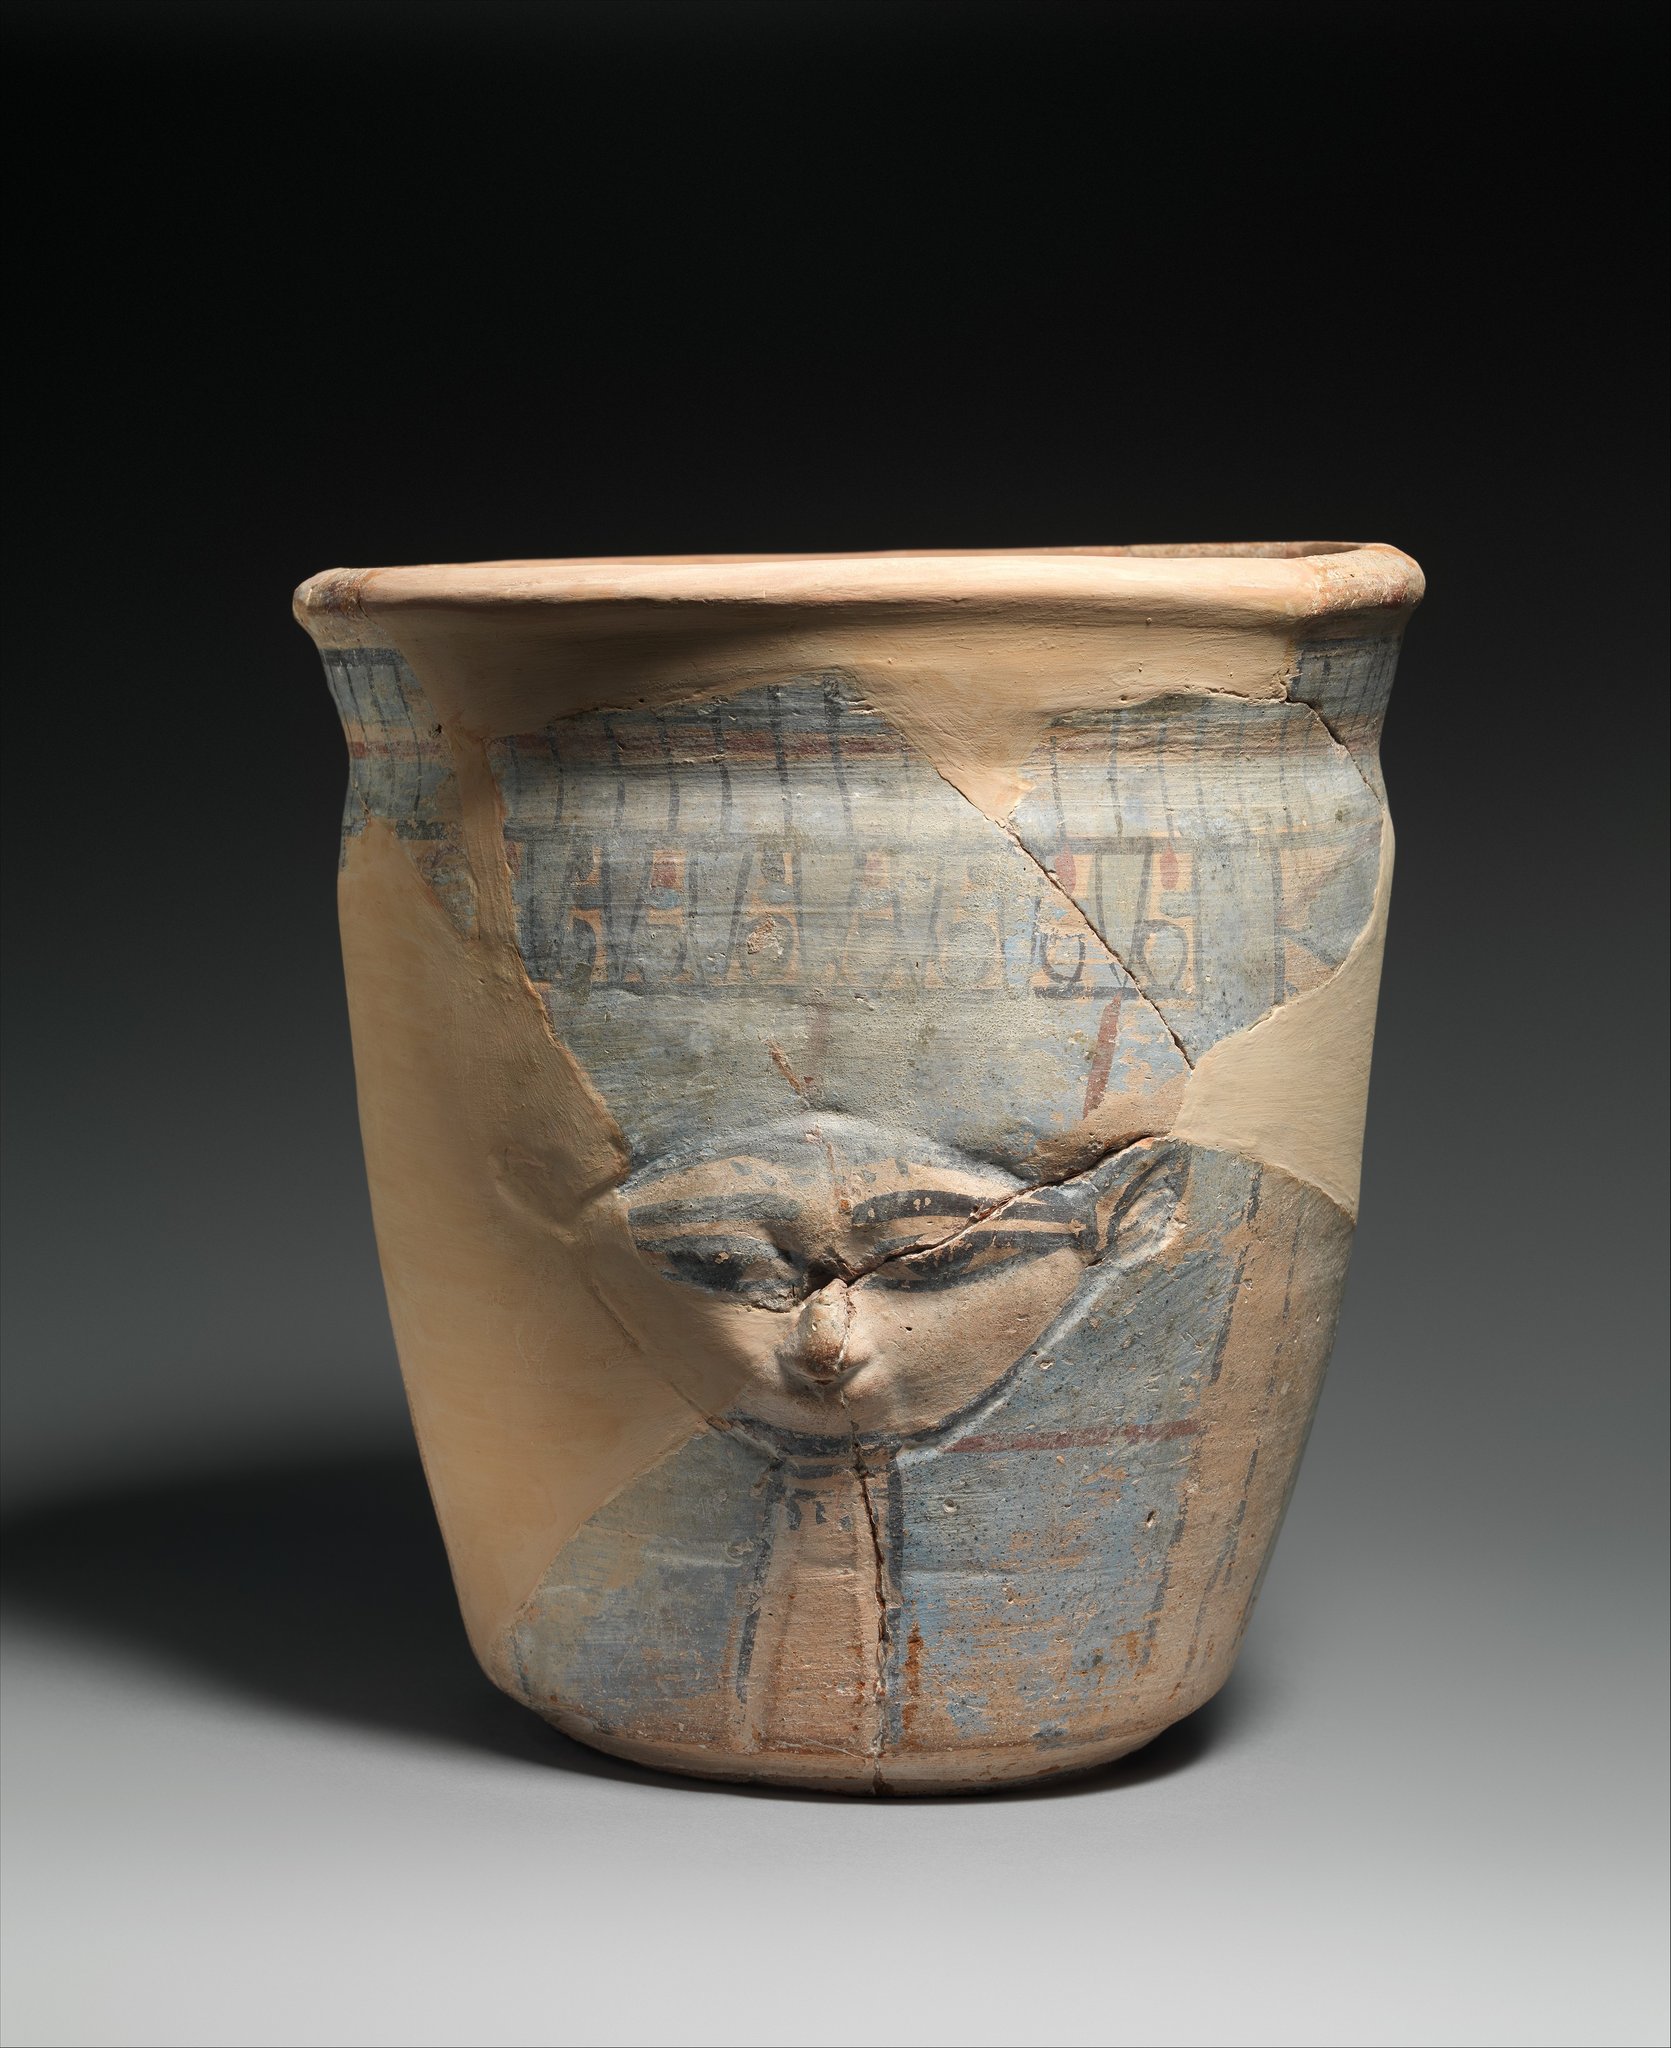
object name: jar, wide mouth, hathor emblem, blue painted ware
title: Upper Portion of a Blue-painted Hathor Jar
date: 1390-1352 BCE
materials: paint, pottery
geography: egypt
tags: hathor